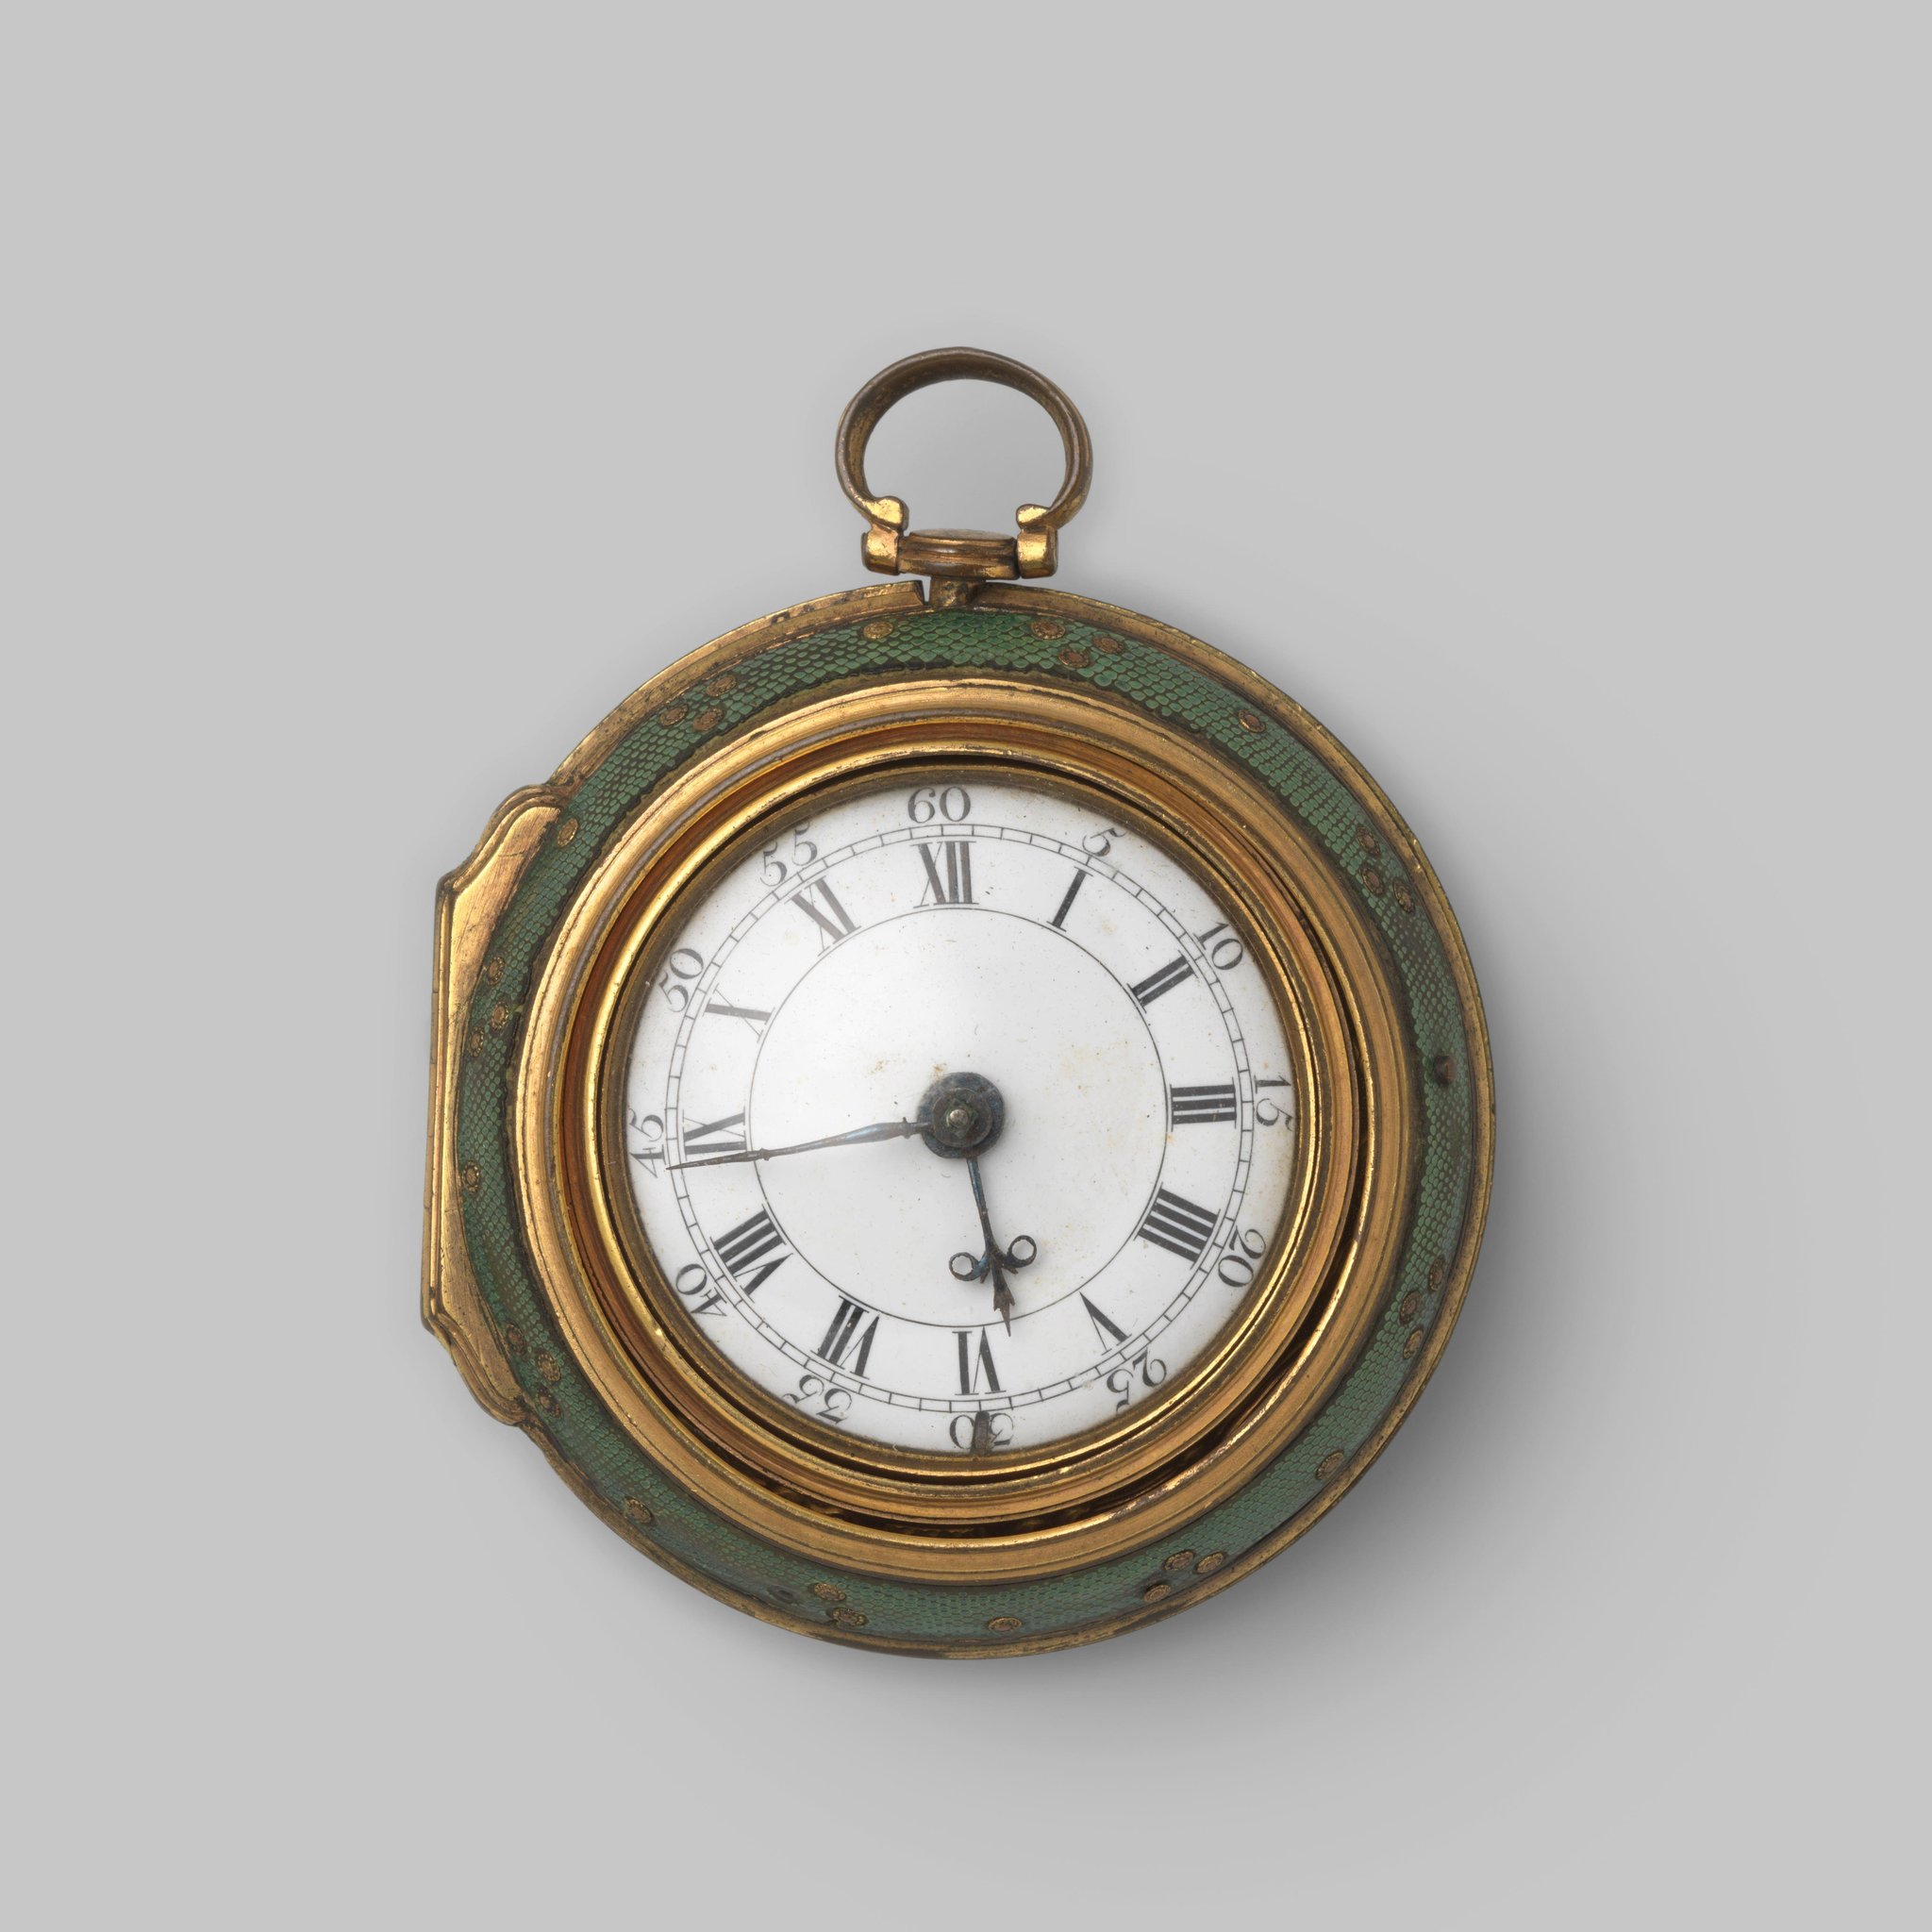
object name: wrist watch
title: Horloge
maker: j. bilson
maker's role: clockmaker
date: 1700-1715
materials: copper, gold, skin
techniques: gilding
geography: london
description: Horloge van verguld koper. In de gedreven gouden kast is een koning of veldheer afgebeeld die zijn linkerhand opheft tegen een vrouw.